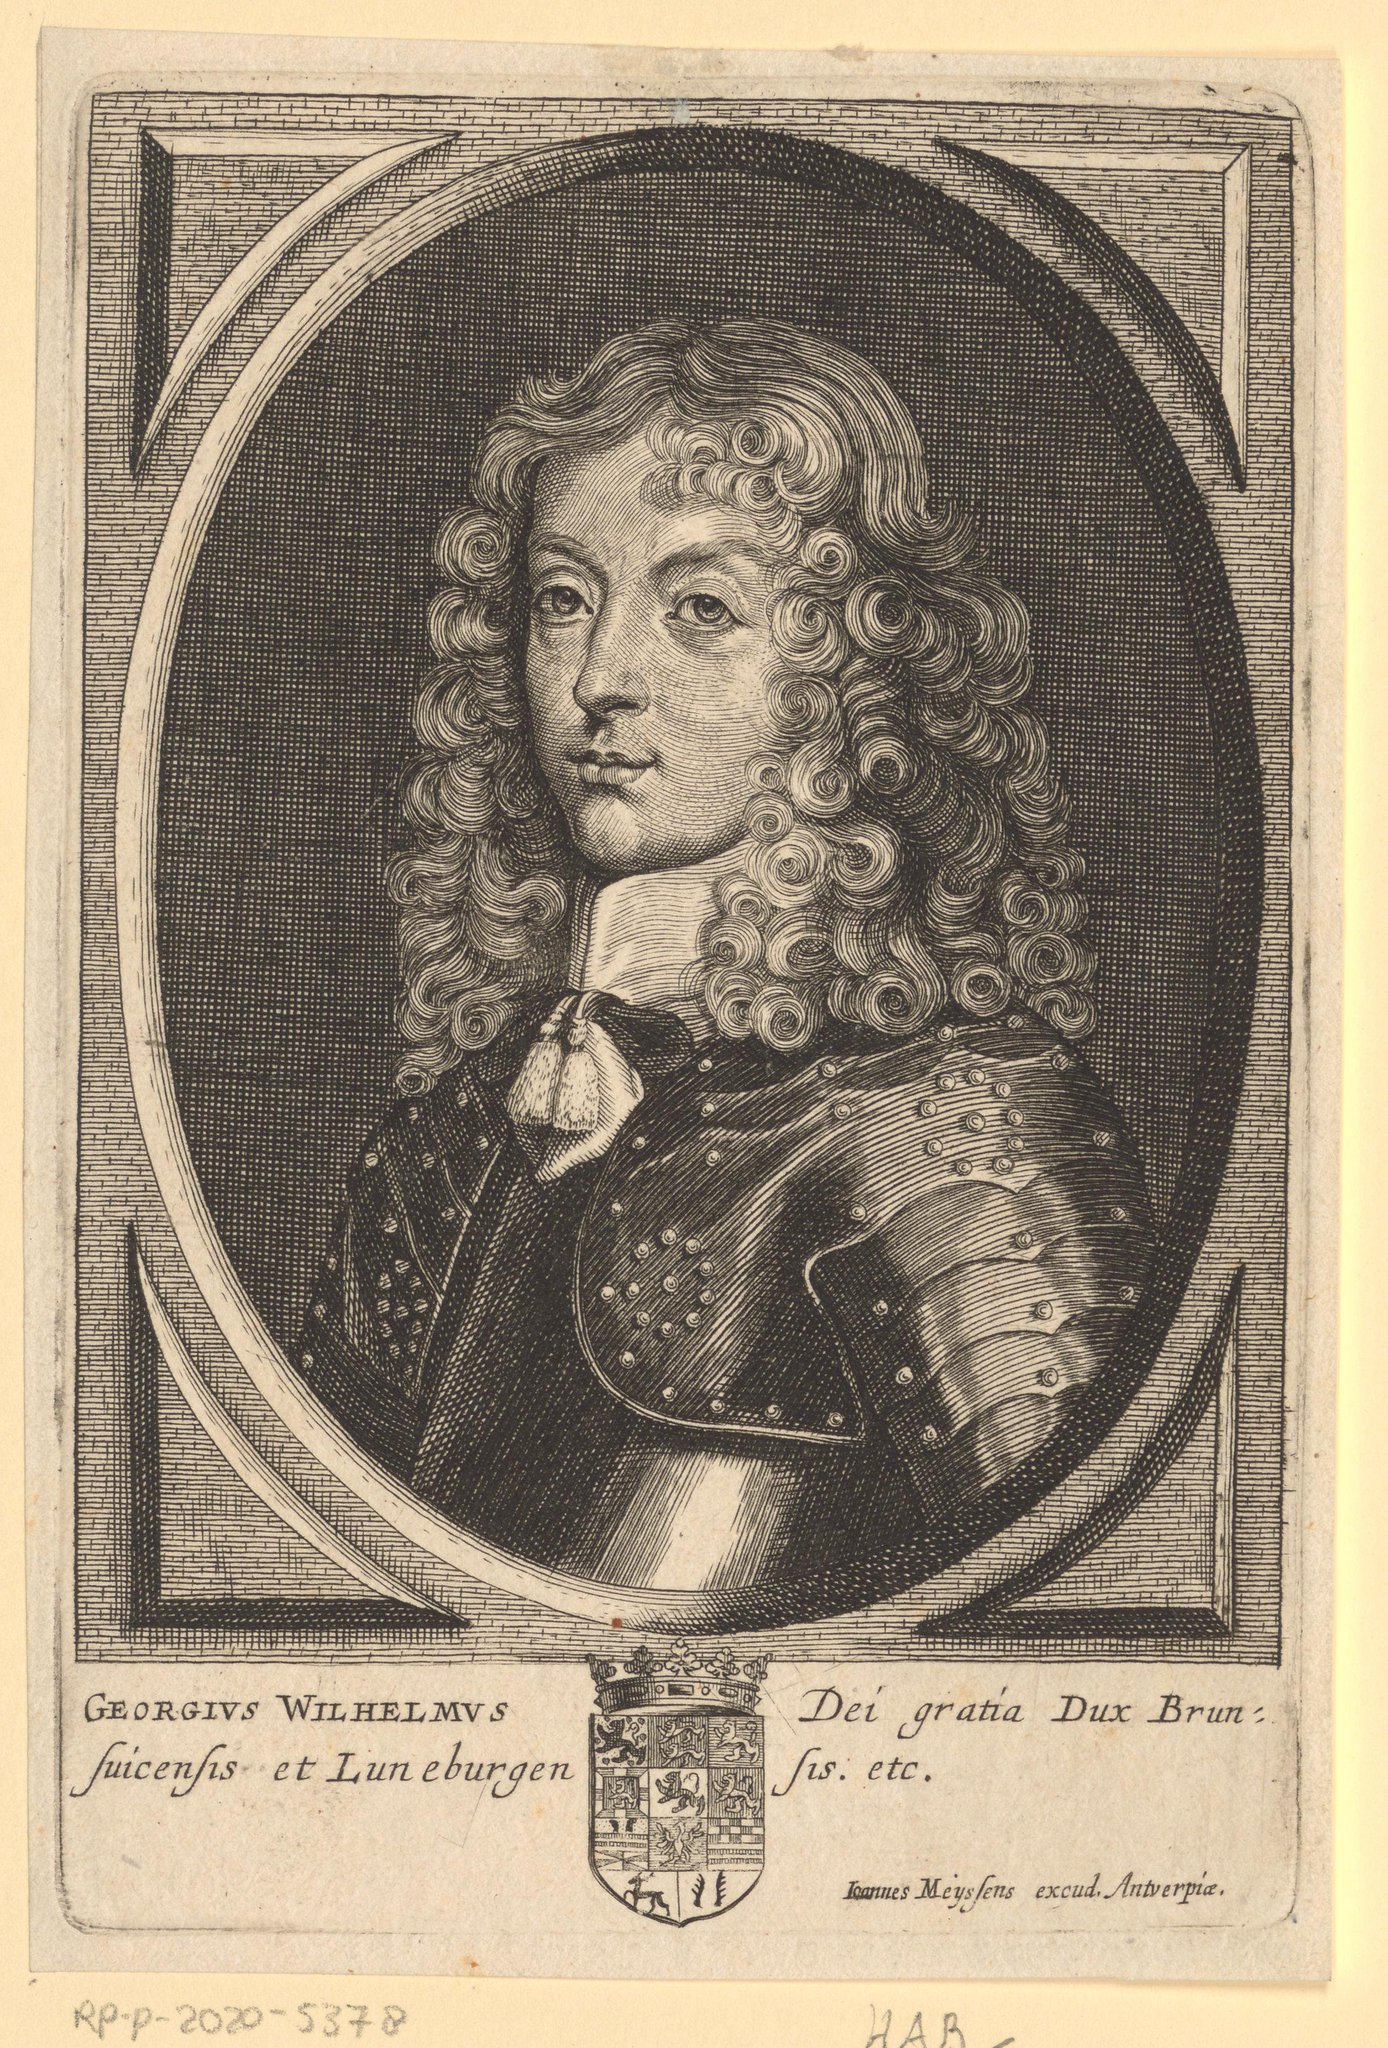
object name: print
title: Portret van Georg von Braunschweig-Lüneburg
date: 1665-1670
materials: paper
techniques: engraving, etching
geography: antwerp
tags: commander-in-chief, general, marshal, historical persons, armorial bearing, heraldry